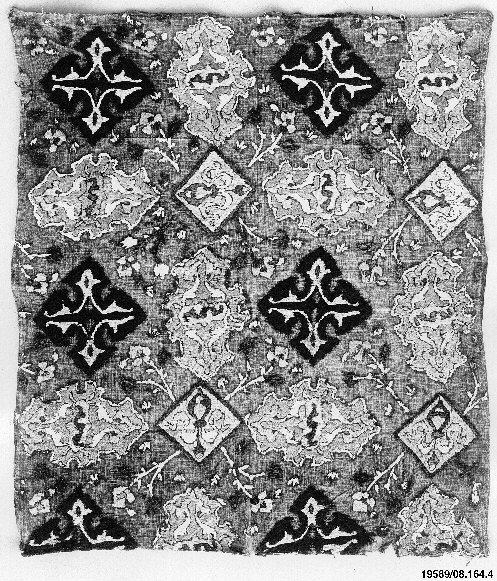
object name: cover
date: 1601-1700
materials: linen, silk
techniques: embroidery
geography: iran